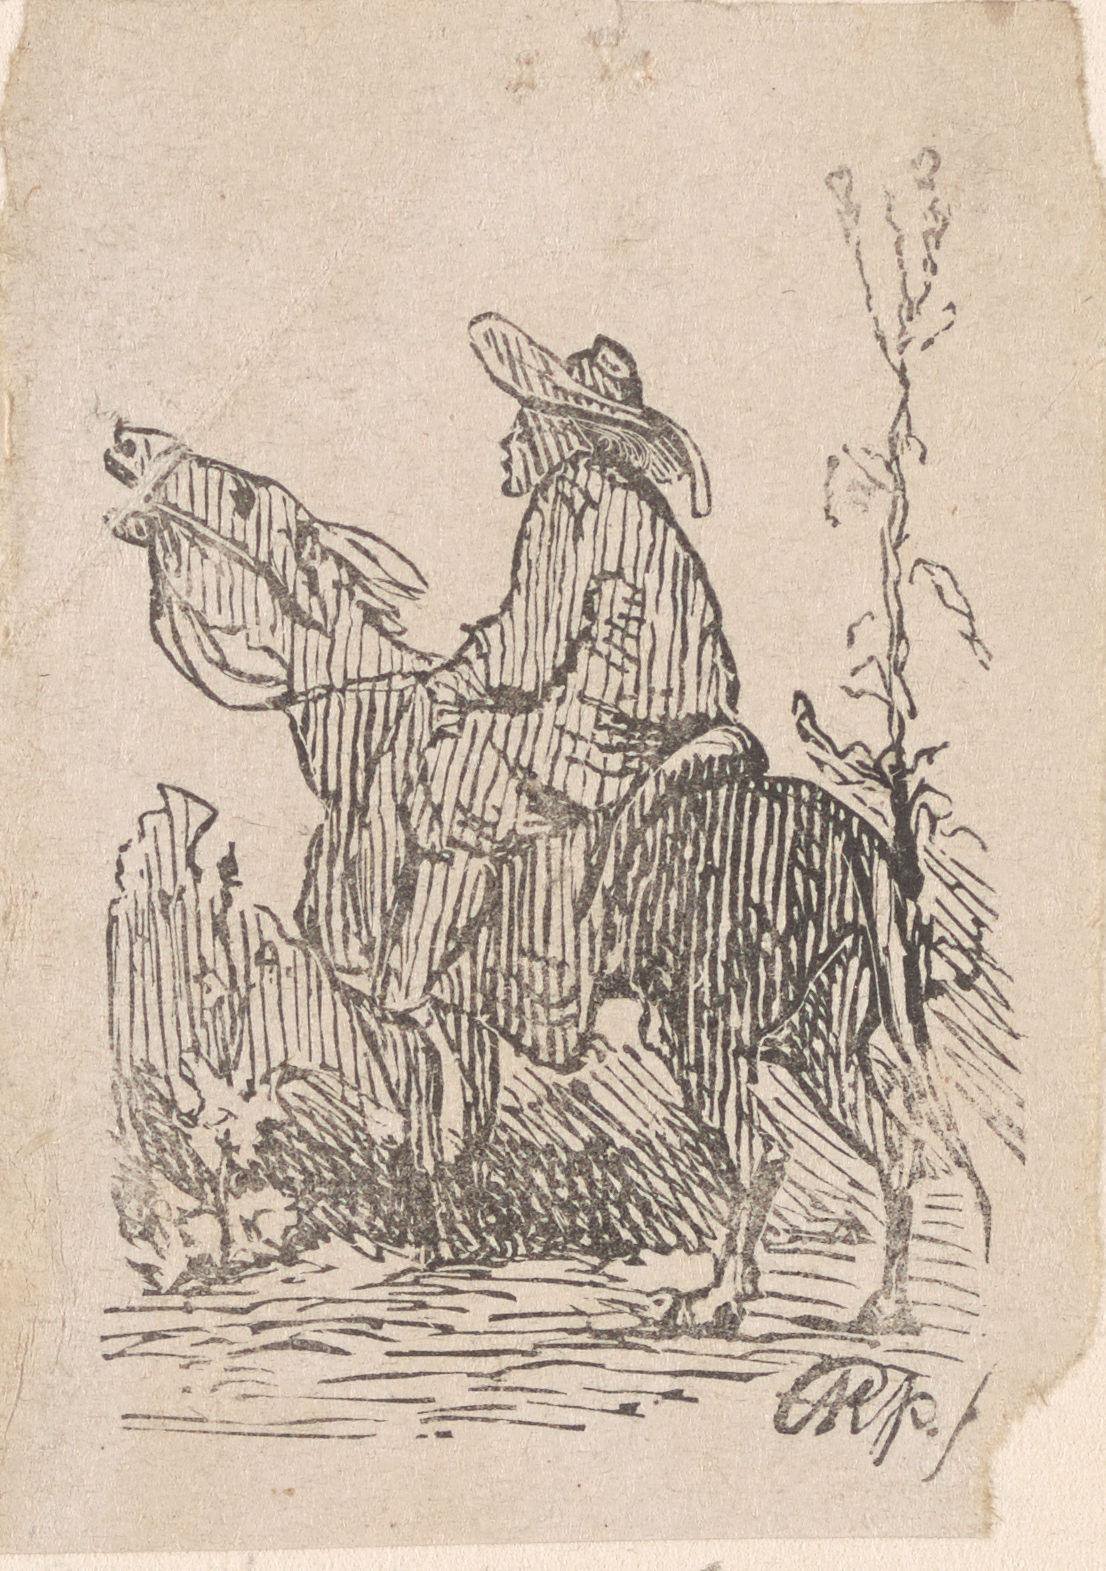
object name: print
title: Man zittend op een balkende ezel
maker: isaac weissenbruch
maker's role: print maker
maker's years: 1826-1912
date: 1836-1912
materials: paper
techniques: engraving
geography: netherlands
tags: ass, donkey, adult man